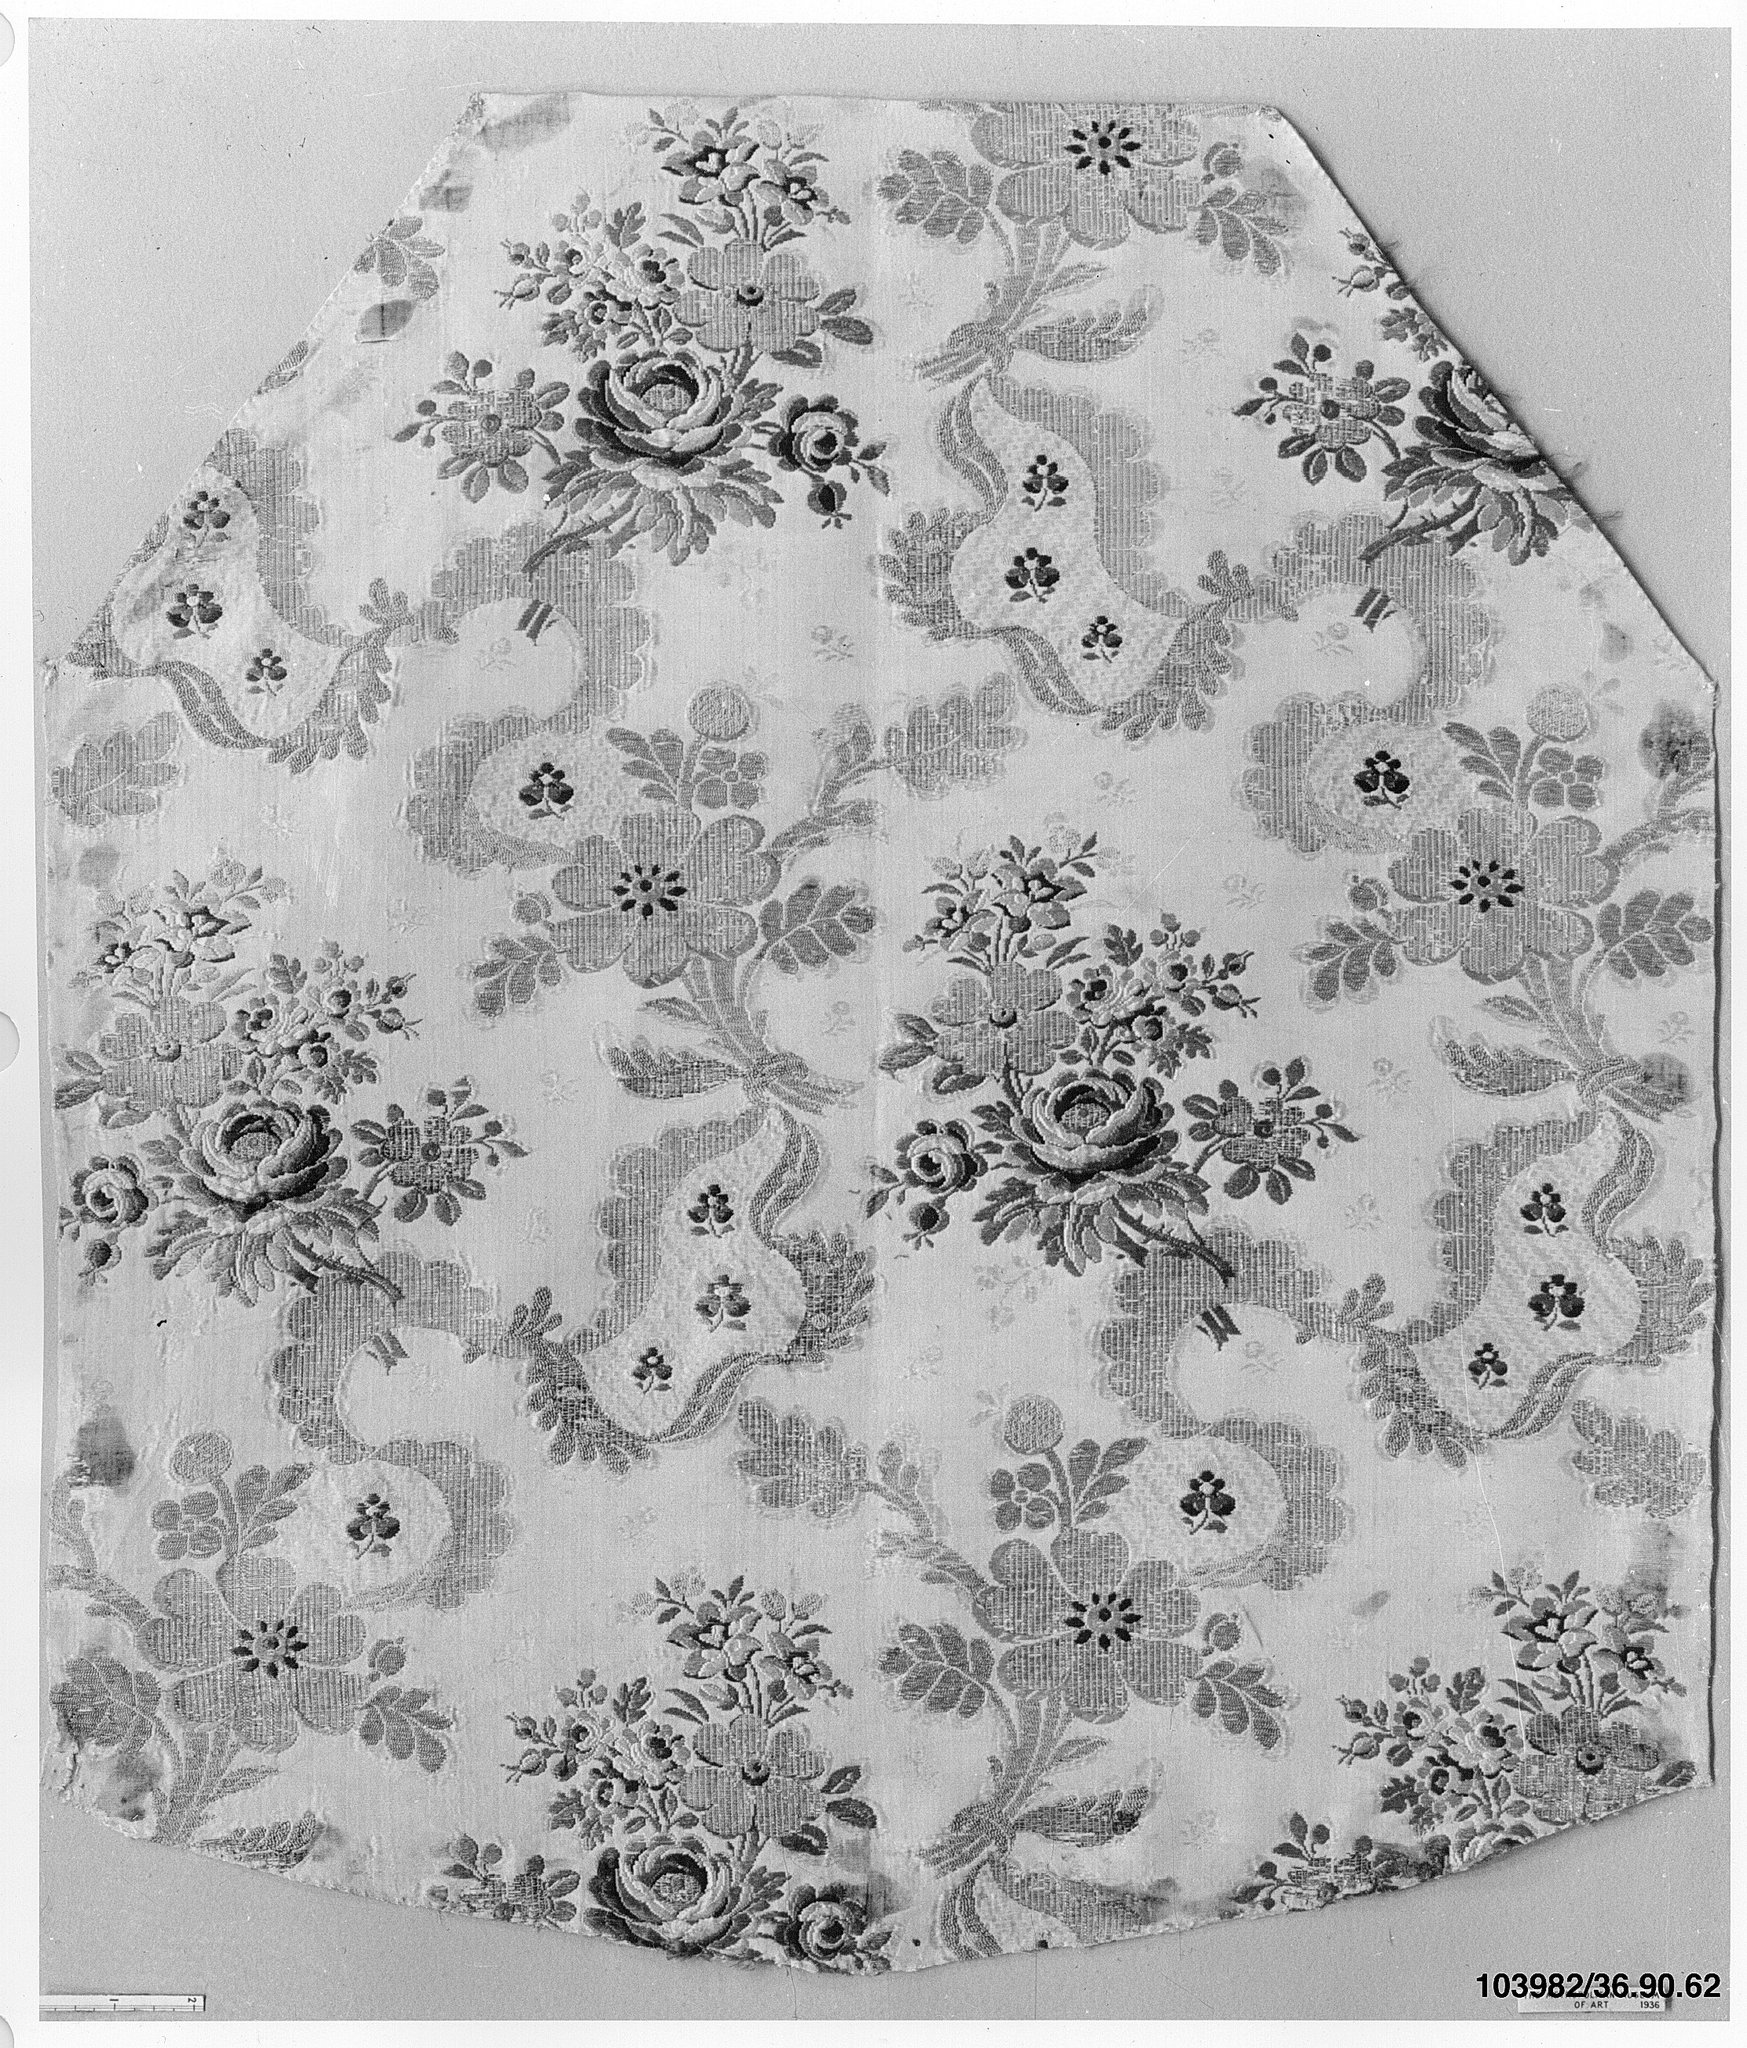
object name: piece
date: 1760-1770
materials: metal thread, silk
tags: flowers